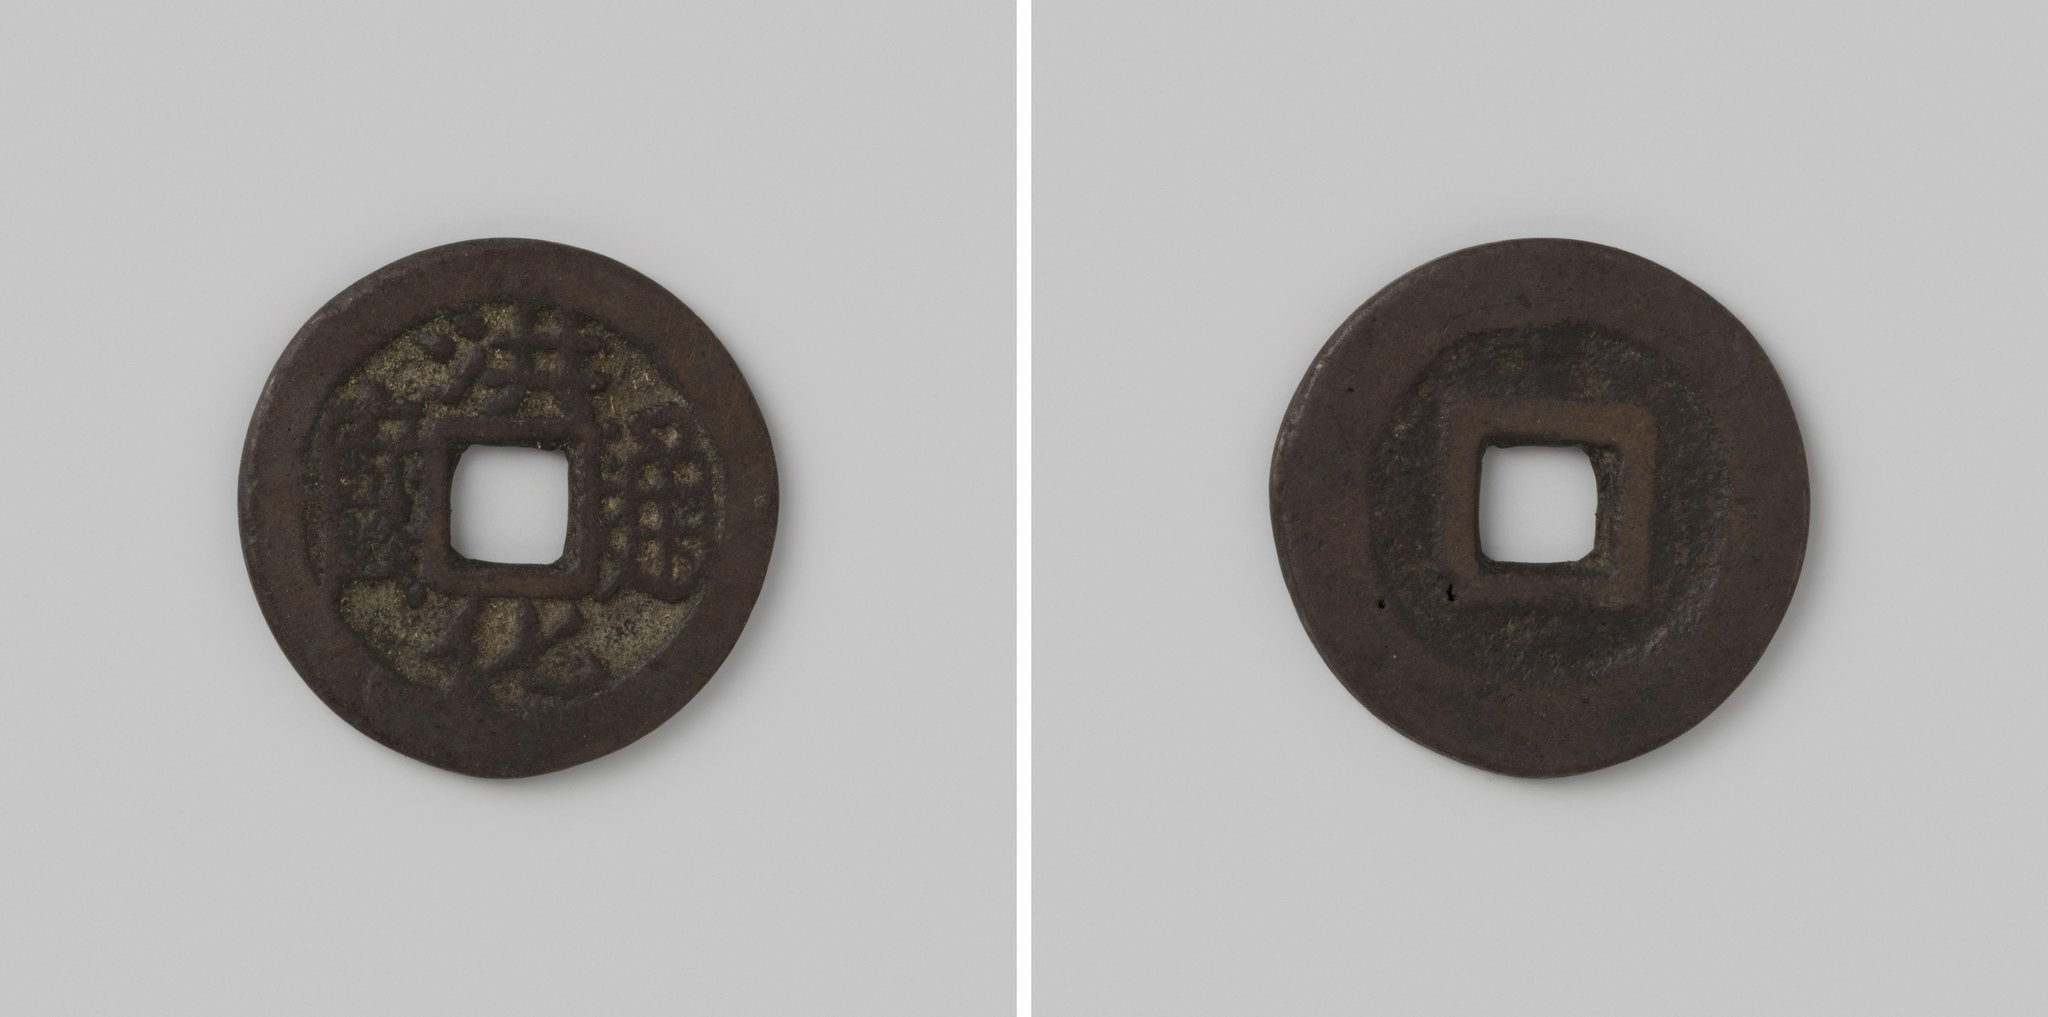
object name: coin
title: Cash van het keizerrijk China van keizer Hui Tsung onder de regeringsnaam Hsuan-Ho,1119 -1125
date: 1119-1125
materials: copper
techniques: casting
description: Koperen munt. Voorzijde: binnen brede opstaande rand rondom vierkante uitsparing in het midden vier kruisgewijze geplaatste Chinese tekens, waarvan twee met de betekenis: Hsuan ho. Keerzijde: glad binnen brede opstaande rand.